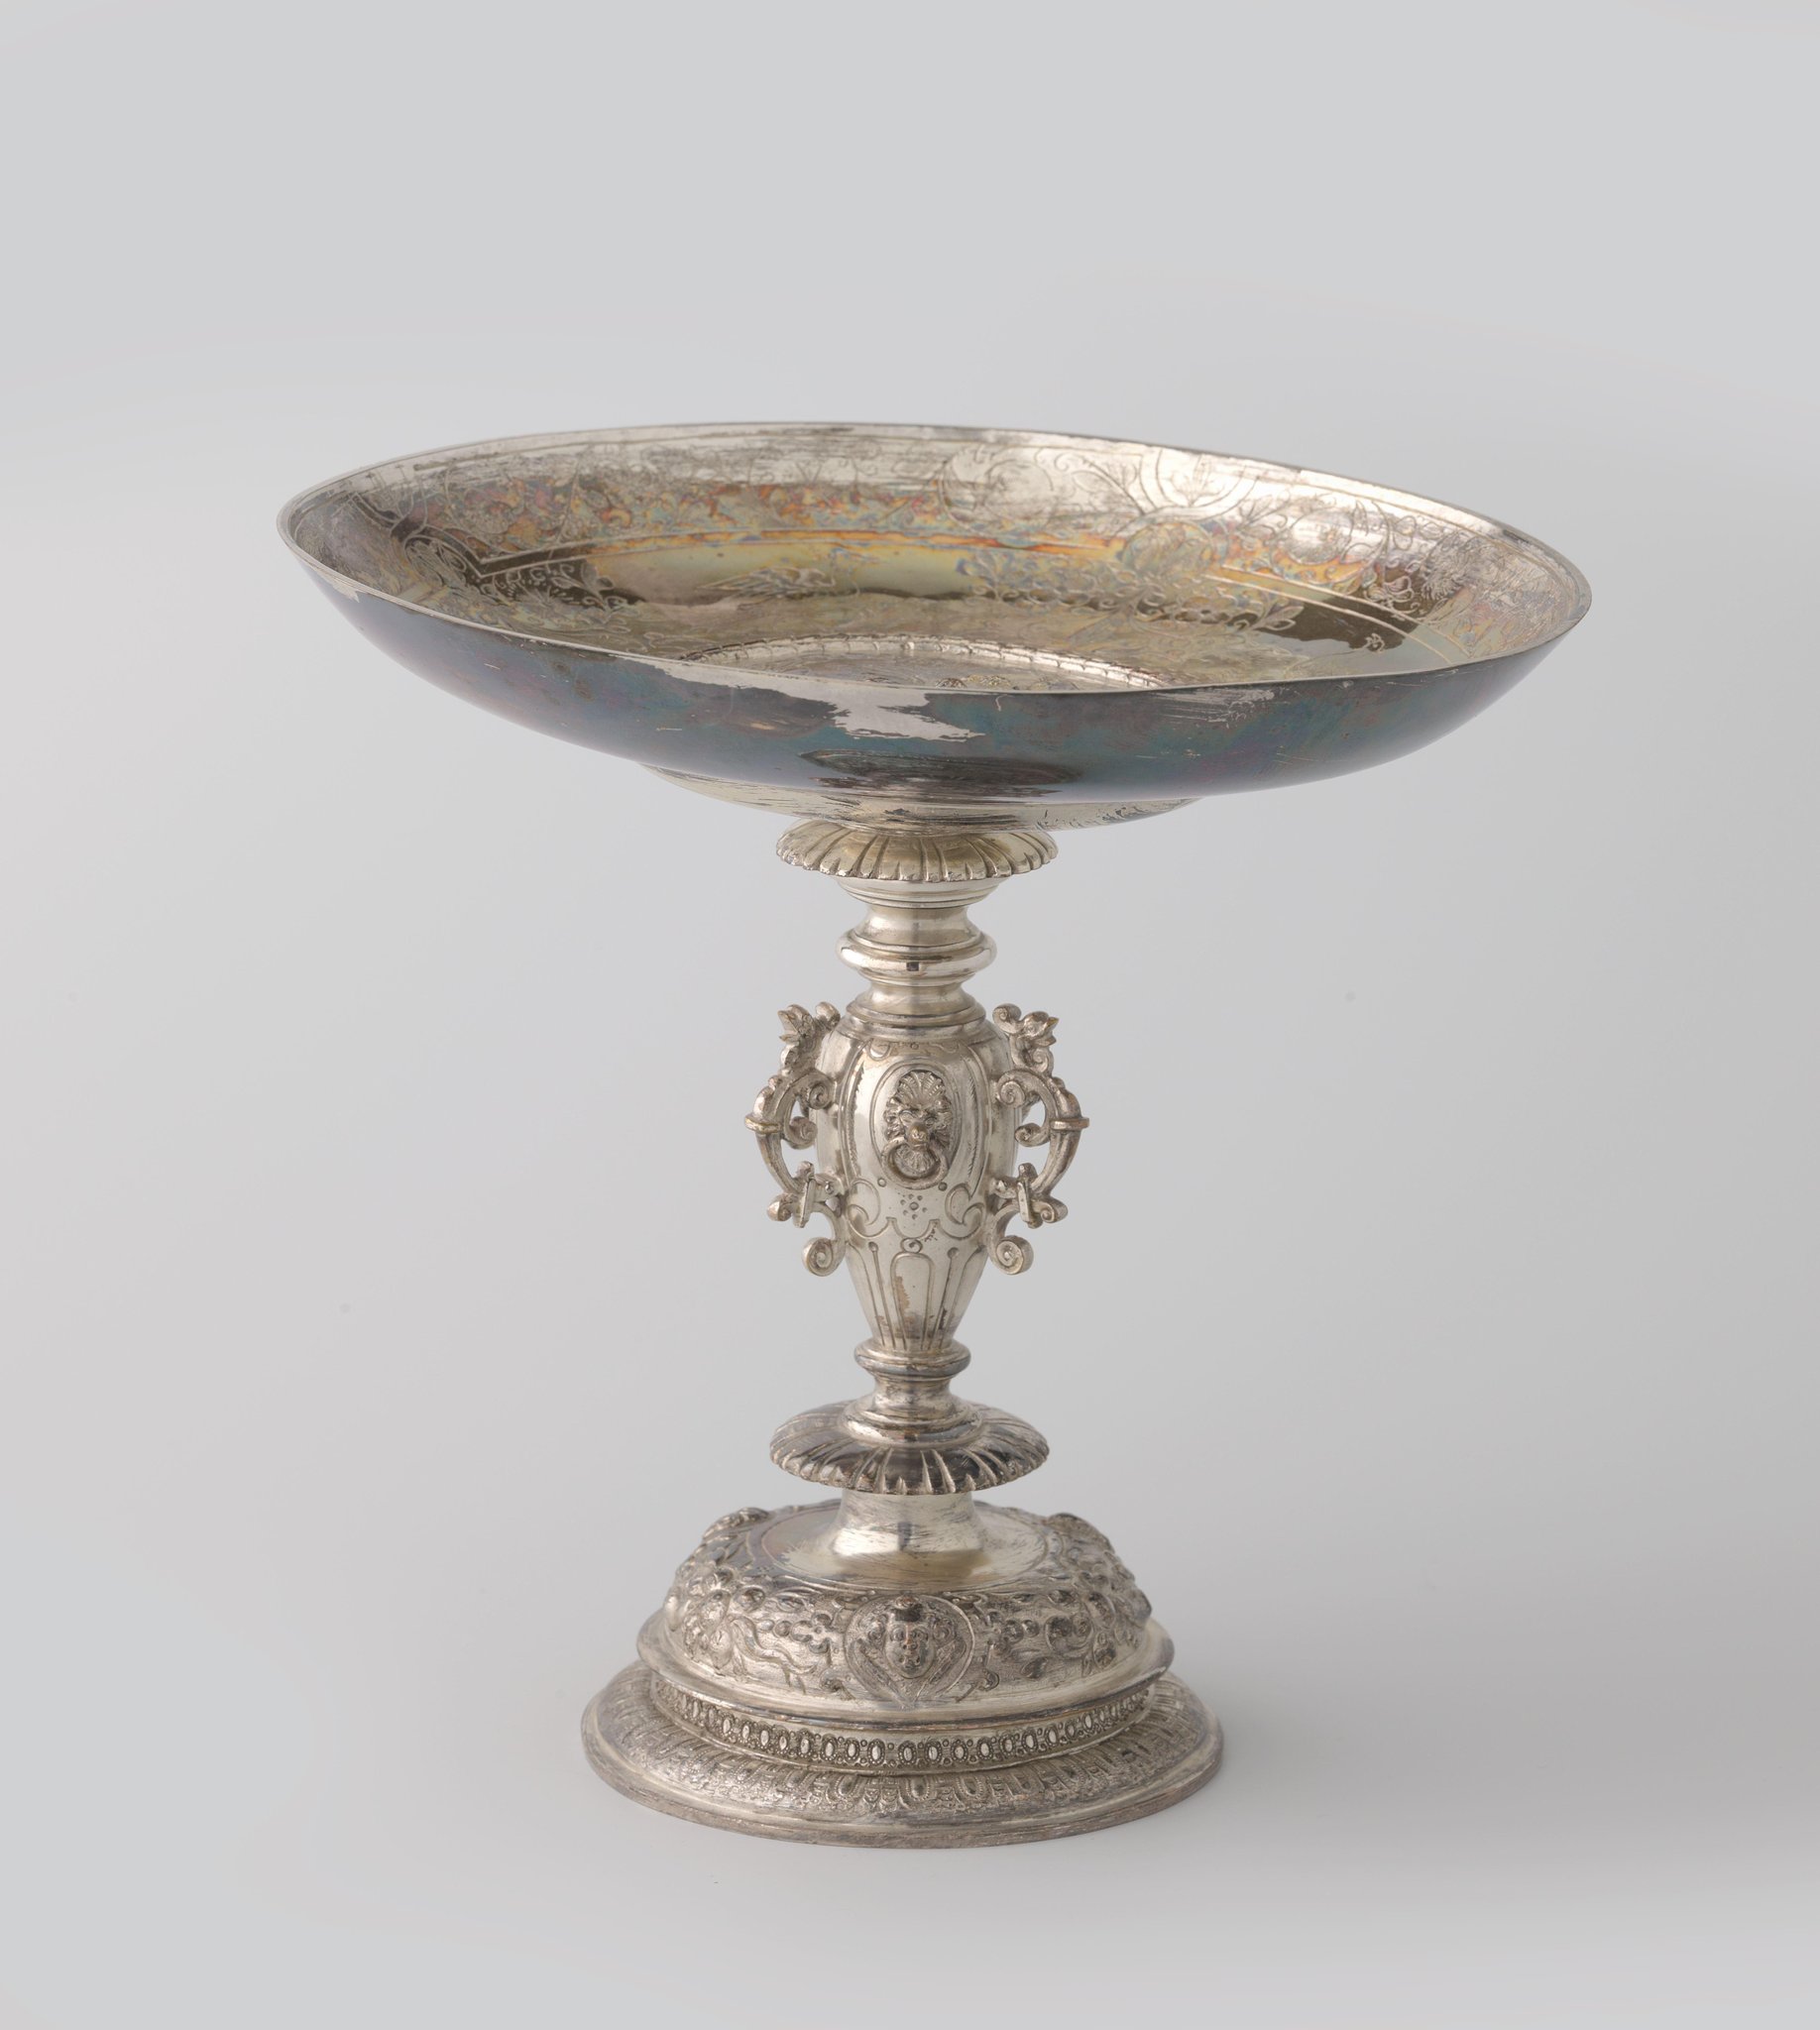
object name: tazza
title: Galvanoplastische reproductie van een tazza met voorstelling van Lot en zijn dochters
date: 1881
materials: copper, silver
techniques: galvanoplasty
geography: london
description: Galvanoplastische reproductie van een tazza. Centraal in een medaillon een voorstelling van Lot en zijn dochters omgeven door vogels en bloemen; de balustervormige stam met leeuwenkoppen en ringen, afgewisseld met haakjes.